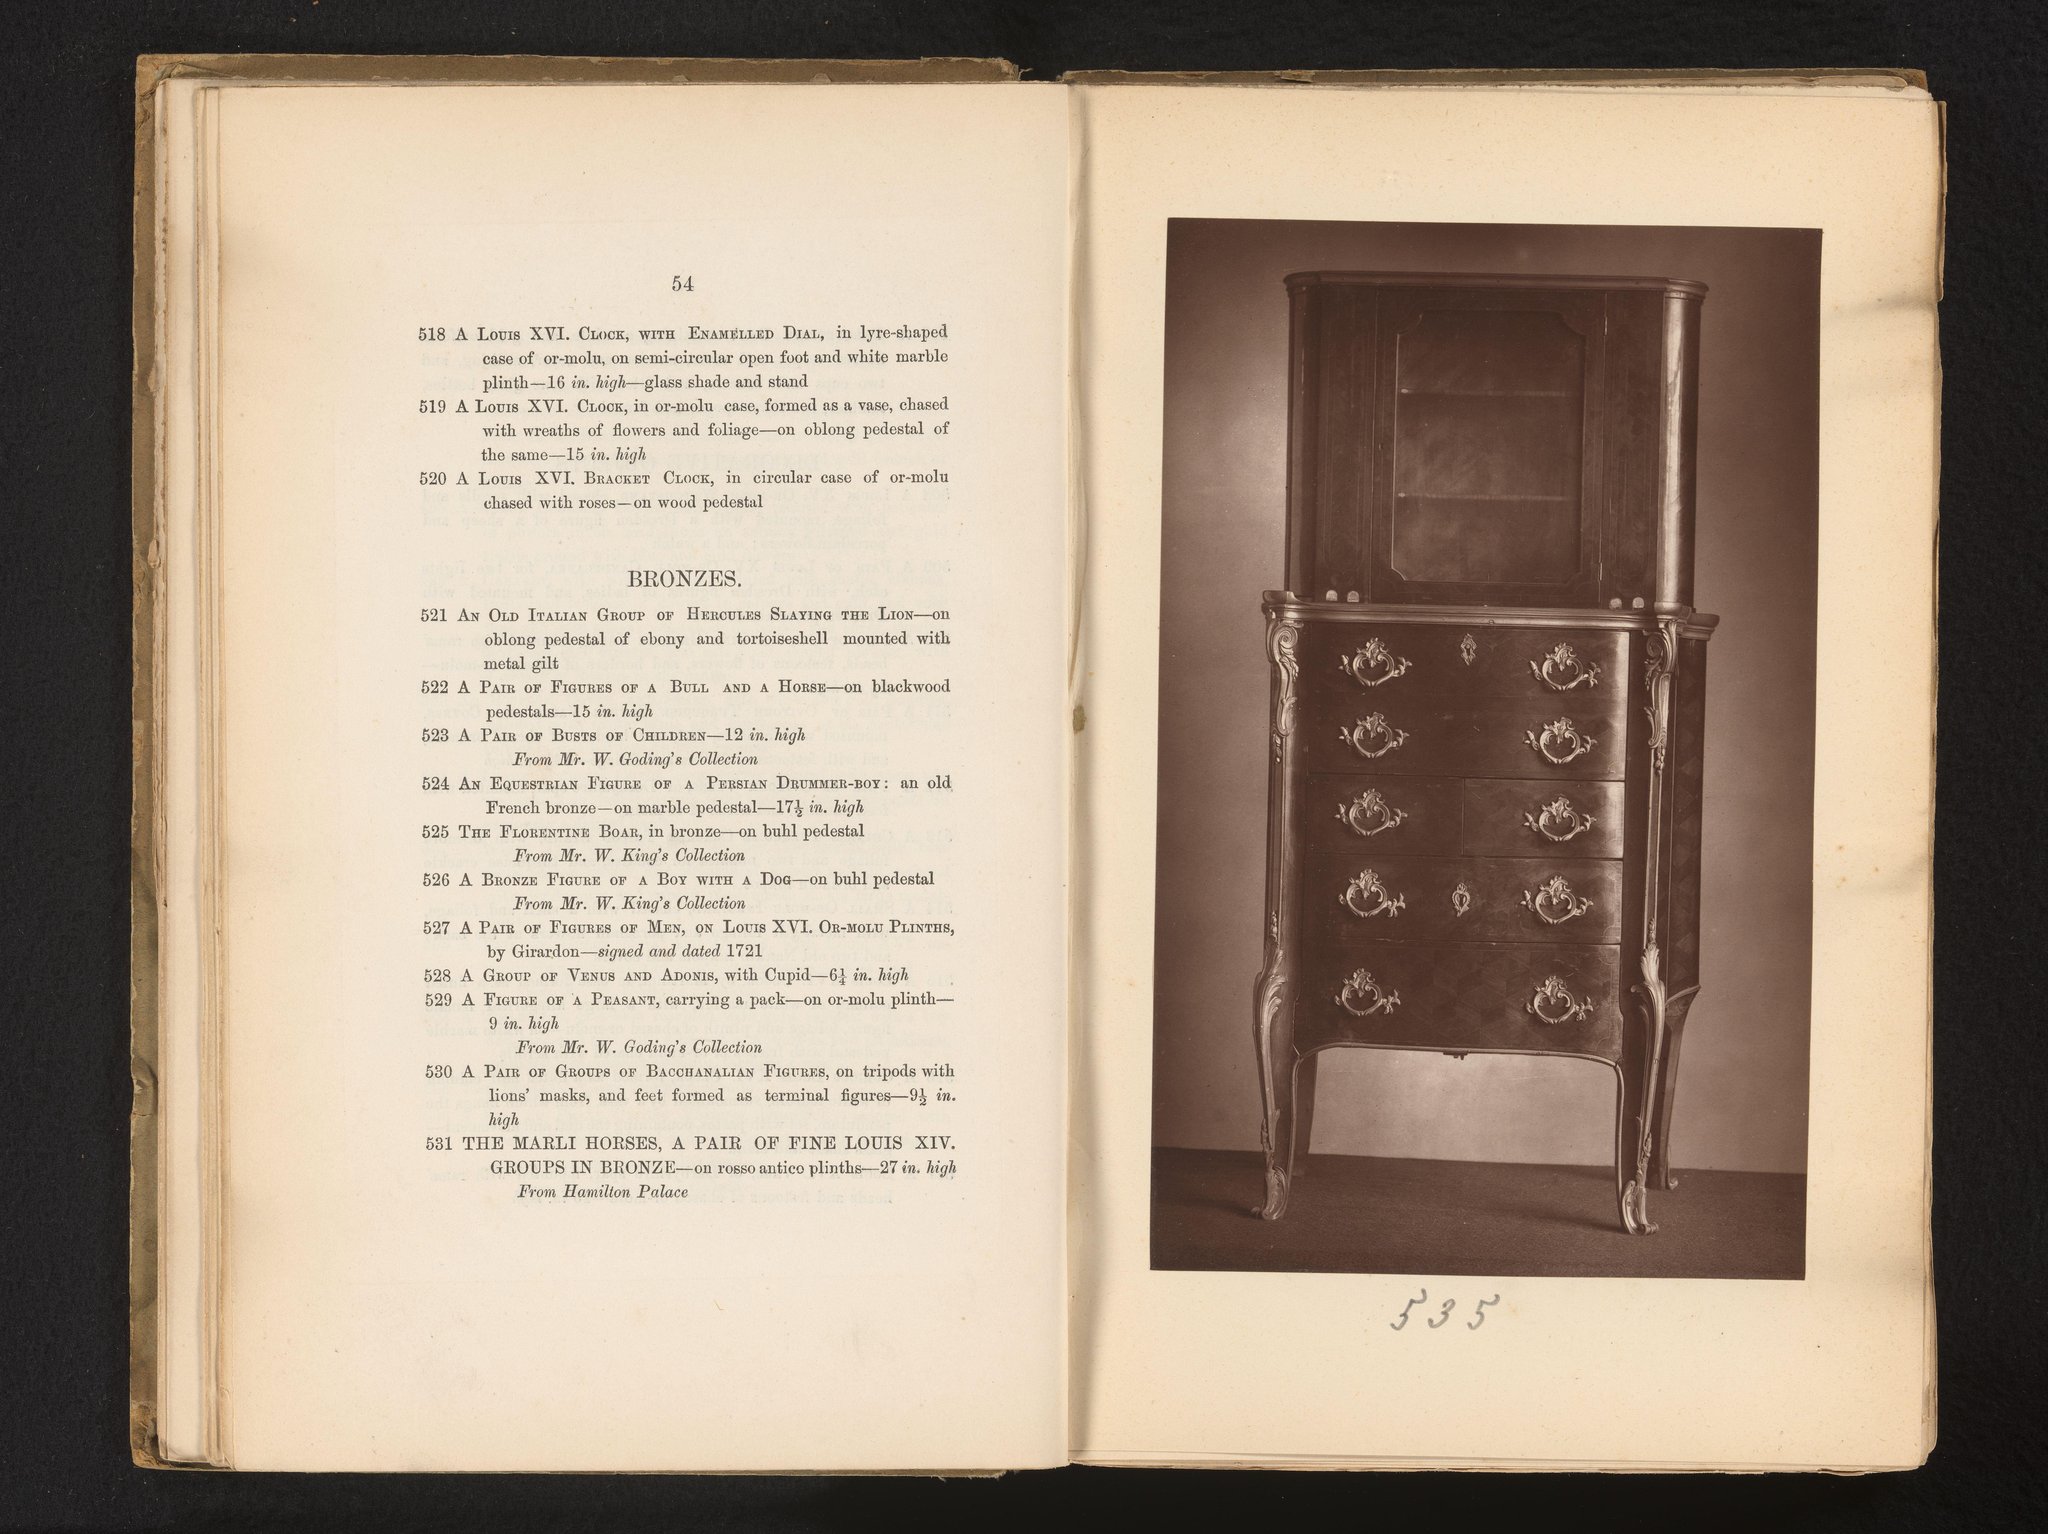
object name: photomechanical print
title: Ladekast in de stijl van Lodewijk XV, uit de collectie van Christopher Beckett Denison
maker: Anonymous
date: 1880-1885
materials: paper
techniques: woodburytype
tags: ornamental cupboard (+ wood and other phytogenic material)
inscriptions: number: ‘535’